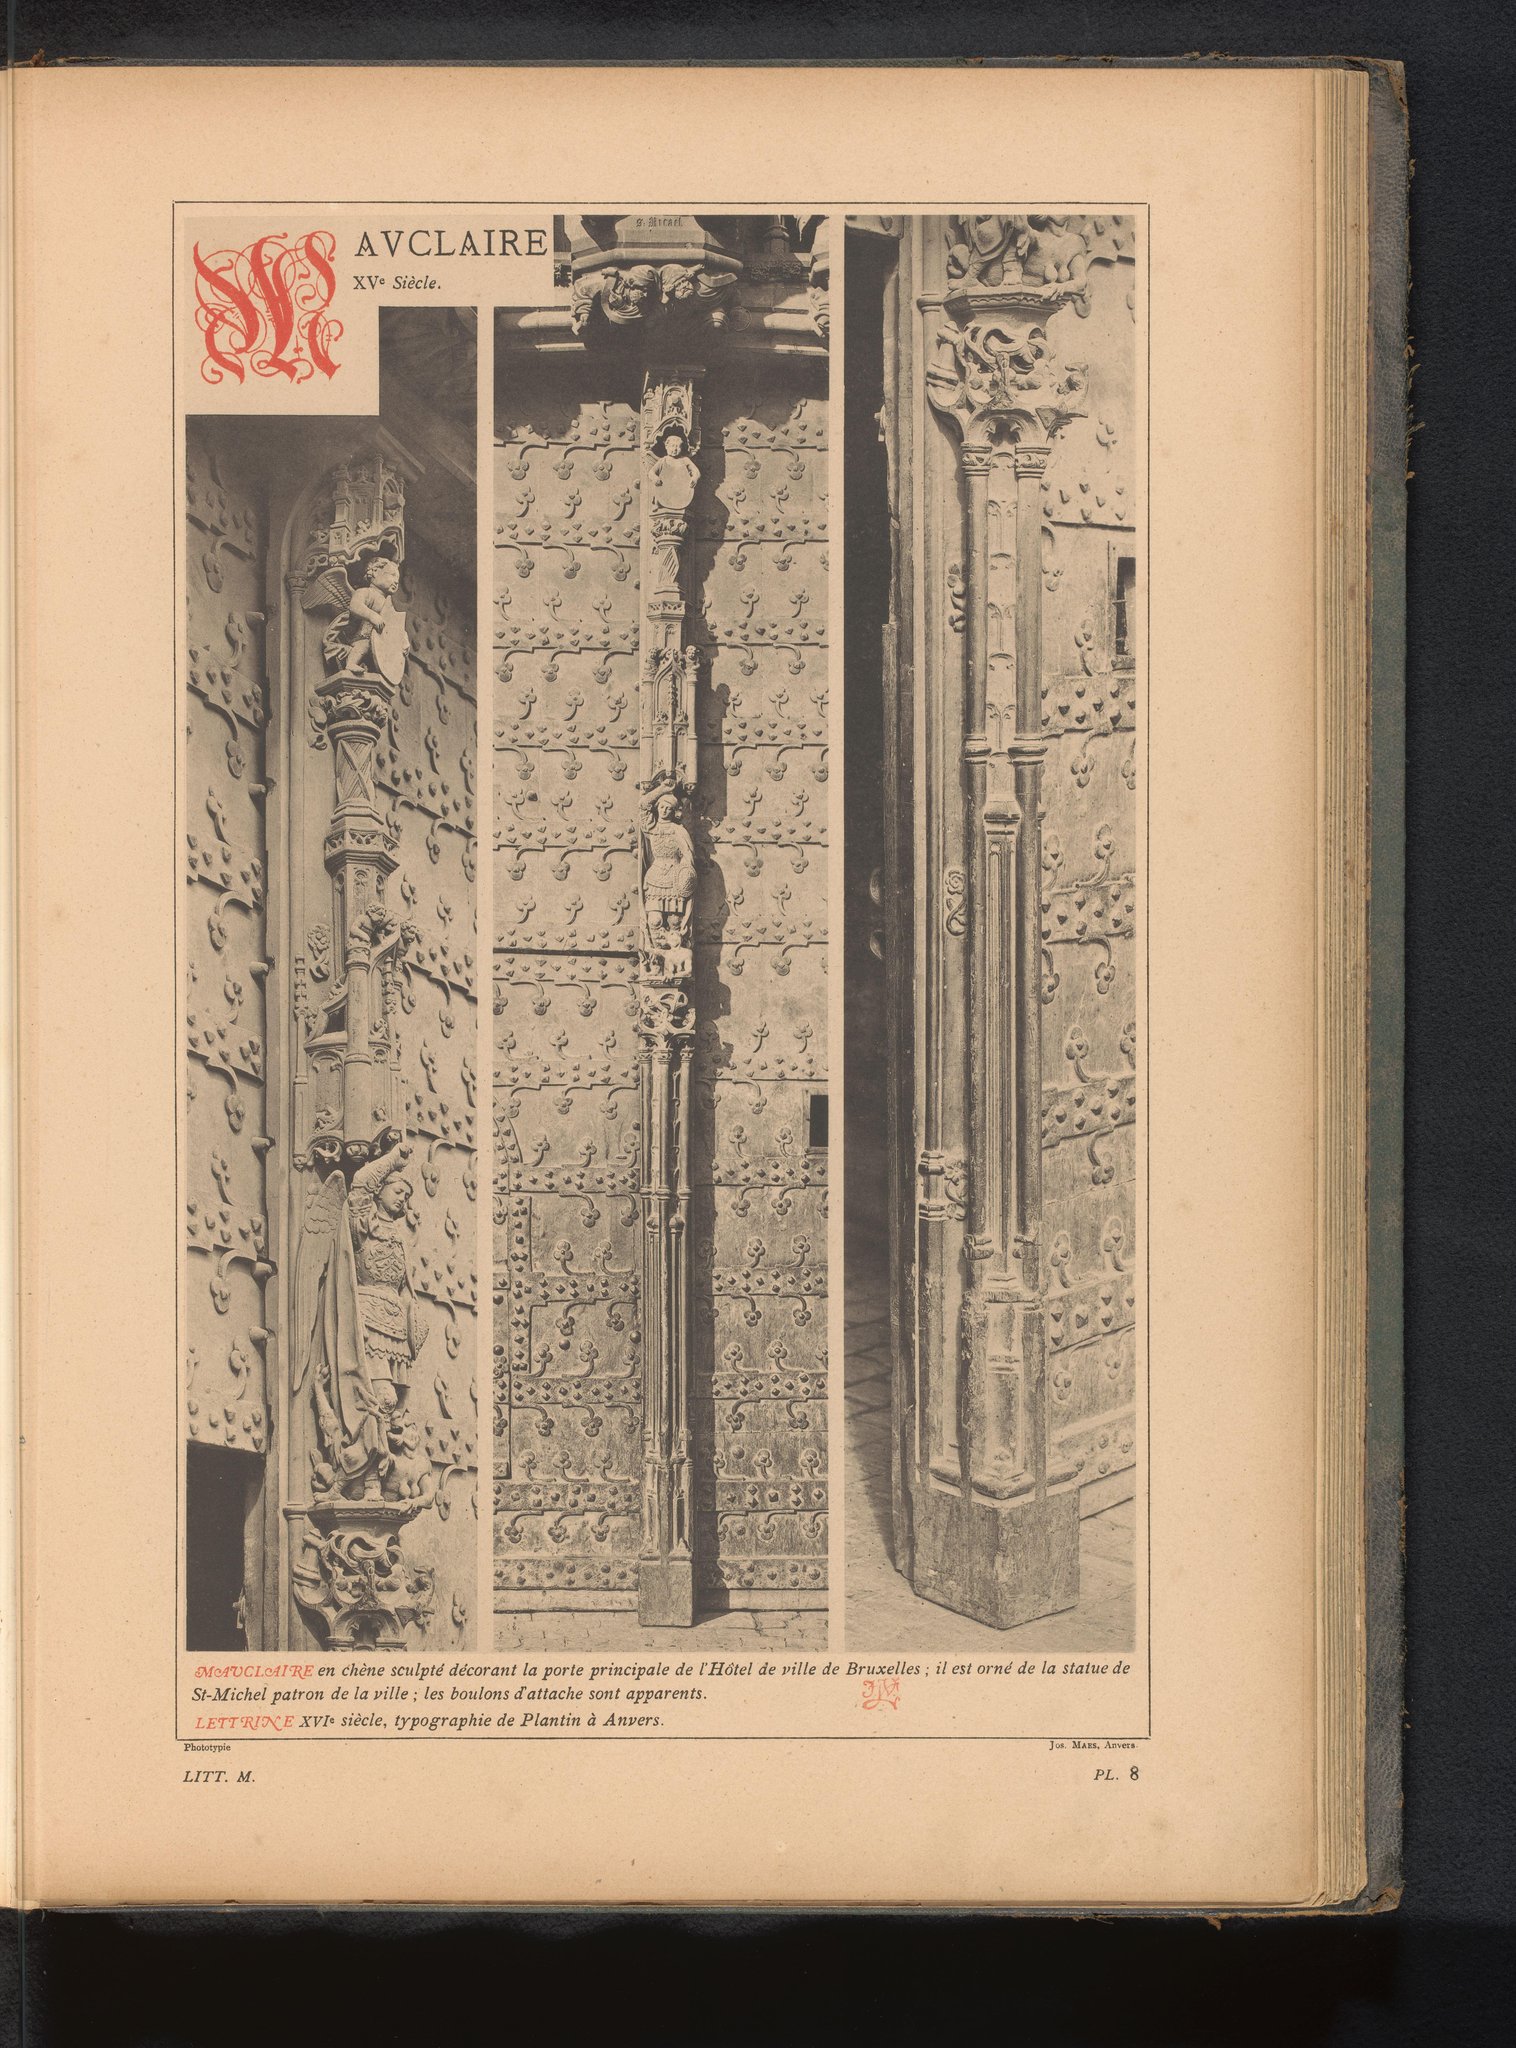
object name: page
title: Mauclaire, XVe Siècle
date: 1875-1880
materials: paper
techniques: photograph, photolithography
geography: antwerp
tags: piece of sculpture, reproduction of a piece of sculpture (+ wood, e.g.: panel ~ arts), column, pillar ~ architecture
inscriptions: inscription: ‘MAUCLAIRE en chène (...)’, inscription: ‘LITT. M. - PL. 8’, monogram: ‘JJvY’